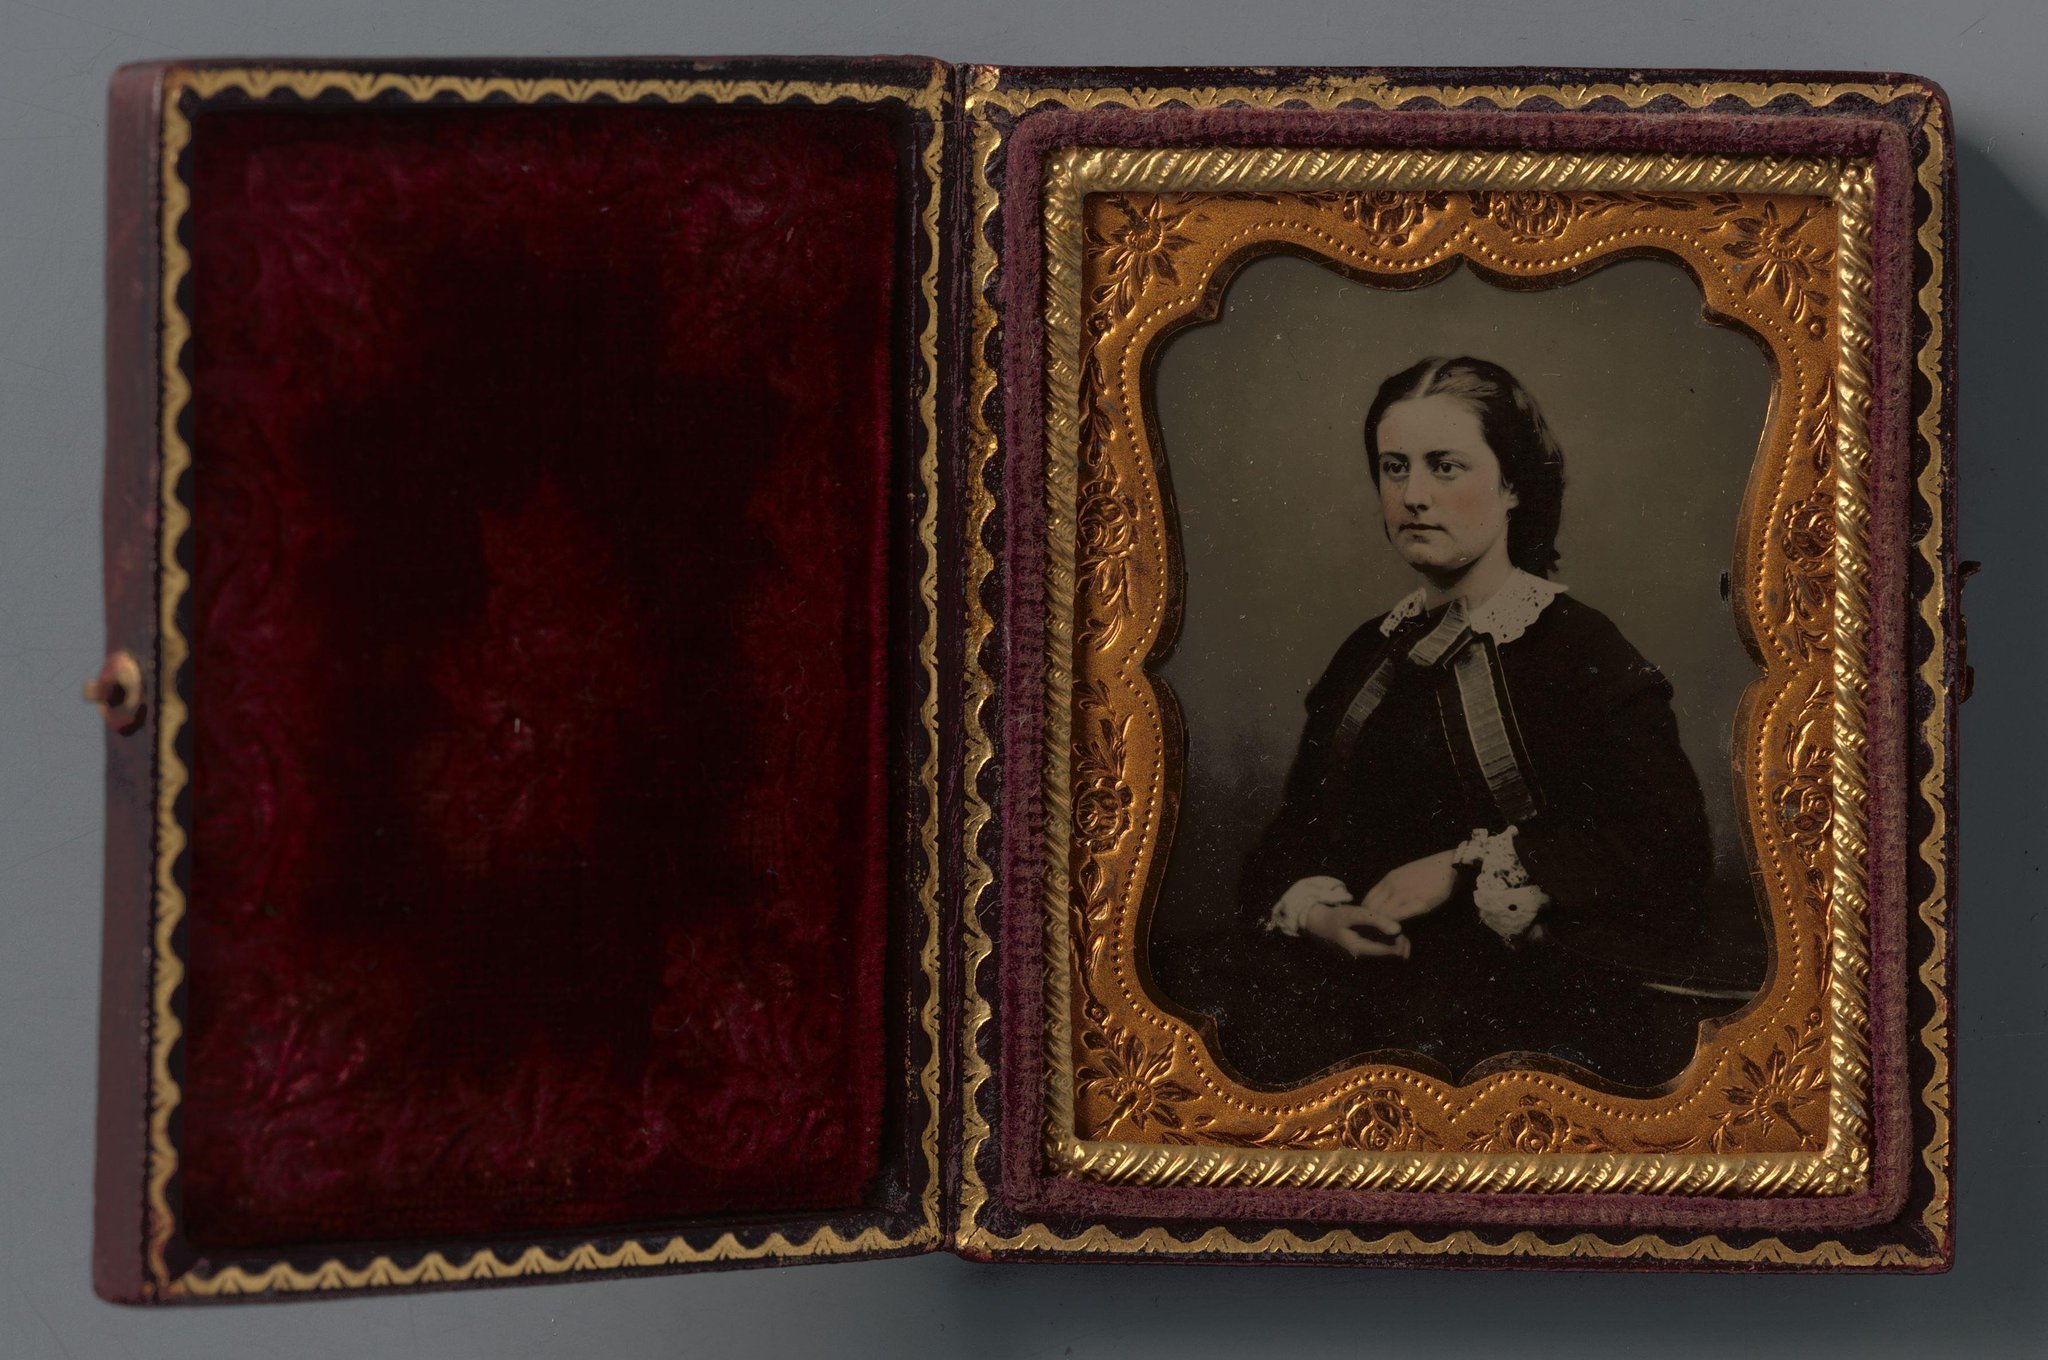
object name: photograph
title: Portret van een onbekende jonge vrouw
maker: Anonymous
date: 1855-1870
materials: glass, metal, velvet, wood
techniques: ambrotype, hand coloring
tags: adolescent, young woman, maiden, historical persons - bb - woman